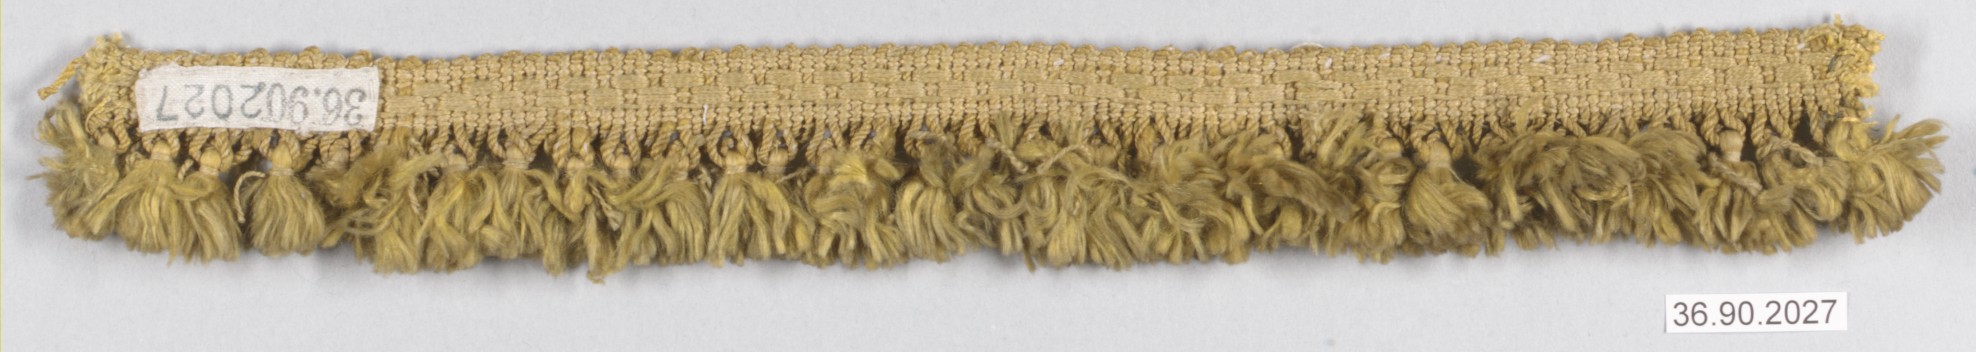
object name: fringe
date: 1801-1833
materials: silk